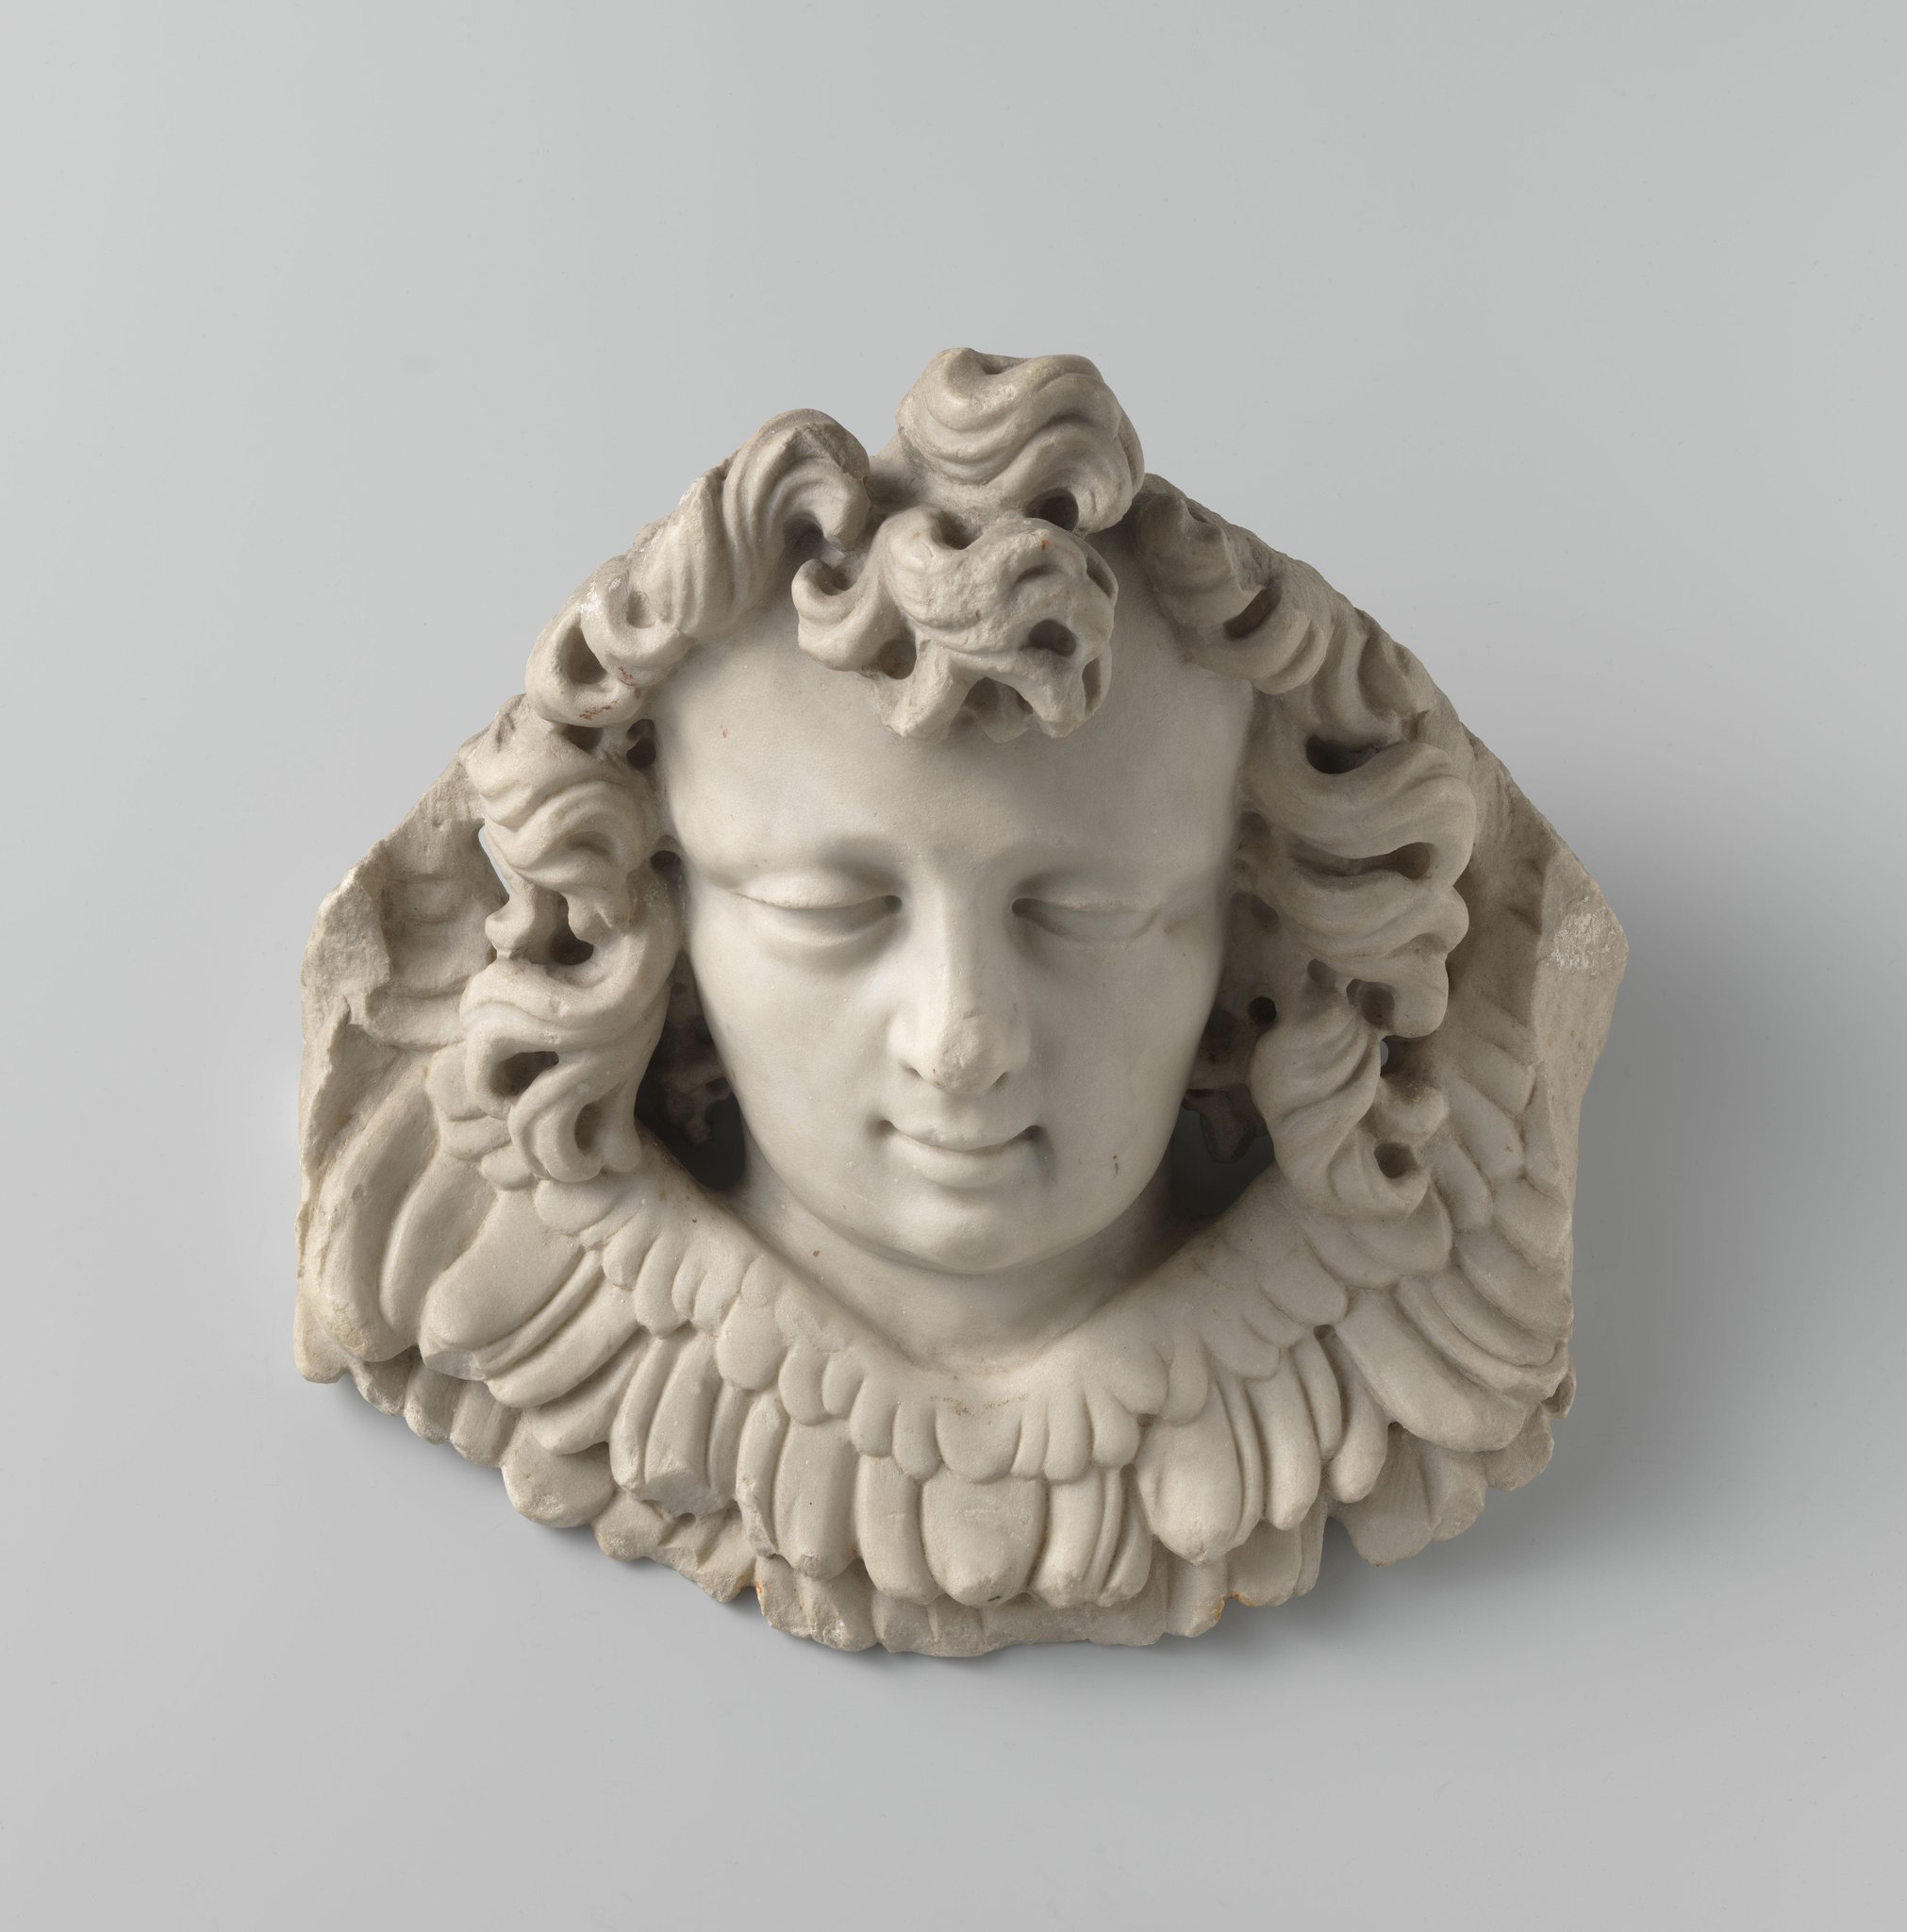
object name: sculpture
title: Head of a Seraph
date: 1600-1660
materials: marble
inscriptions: number, on the reverse, in red crayon: ‘63’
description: Wit marmeren engelenkop met sterk krullend haar en veren, die als een kraag tegen de hals liggen.